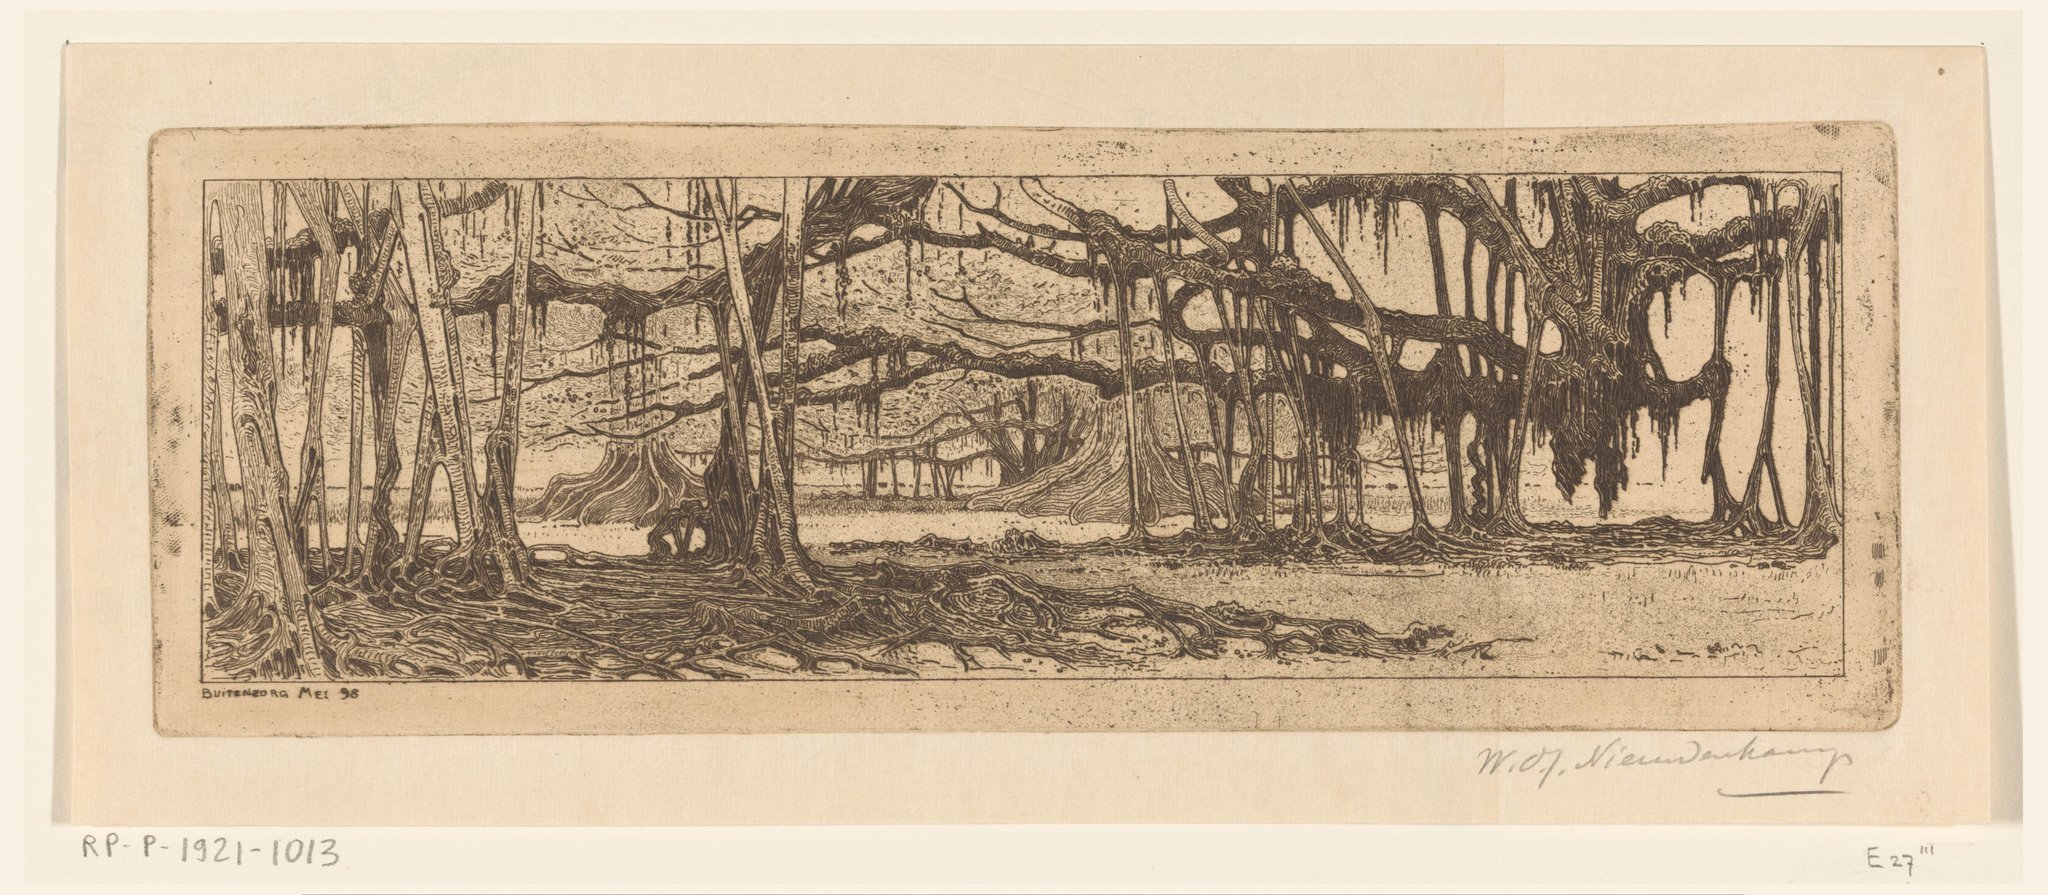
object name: print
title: Waringinbomen in een tuin in Buitenzorg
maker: wijnand otto jan nieuwenkamp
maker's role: draughtsman, print maker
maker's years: 1874-1950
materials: paper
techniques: intaglio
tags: trees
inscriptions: collector's mark: Lugt 2233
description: Waringinbomen, ook wel treurvijgen genoemd, met luchtwortels, in een tuin in Buitenzorg, het tegenwoordige Bogor. Op verso een fragment van een ets met zeilschepen op zee.